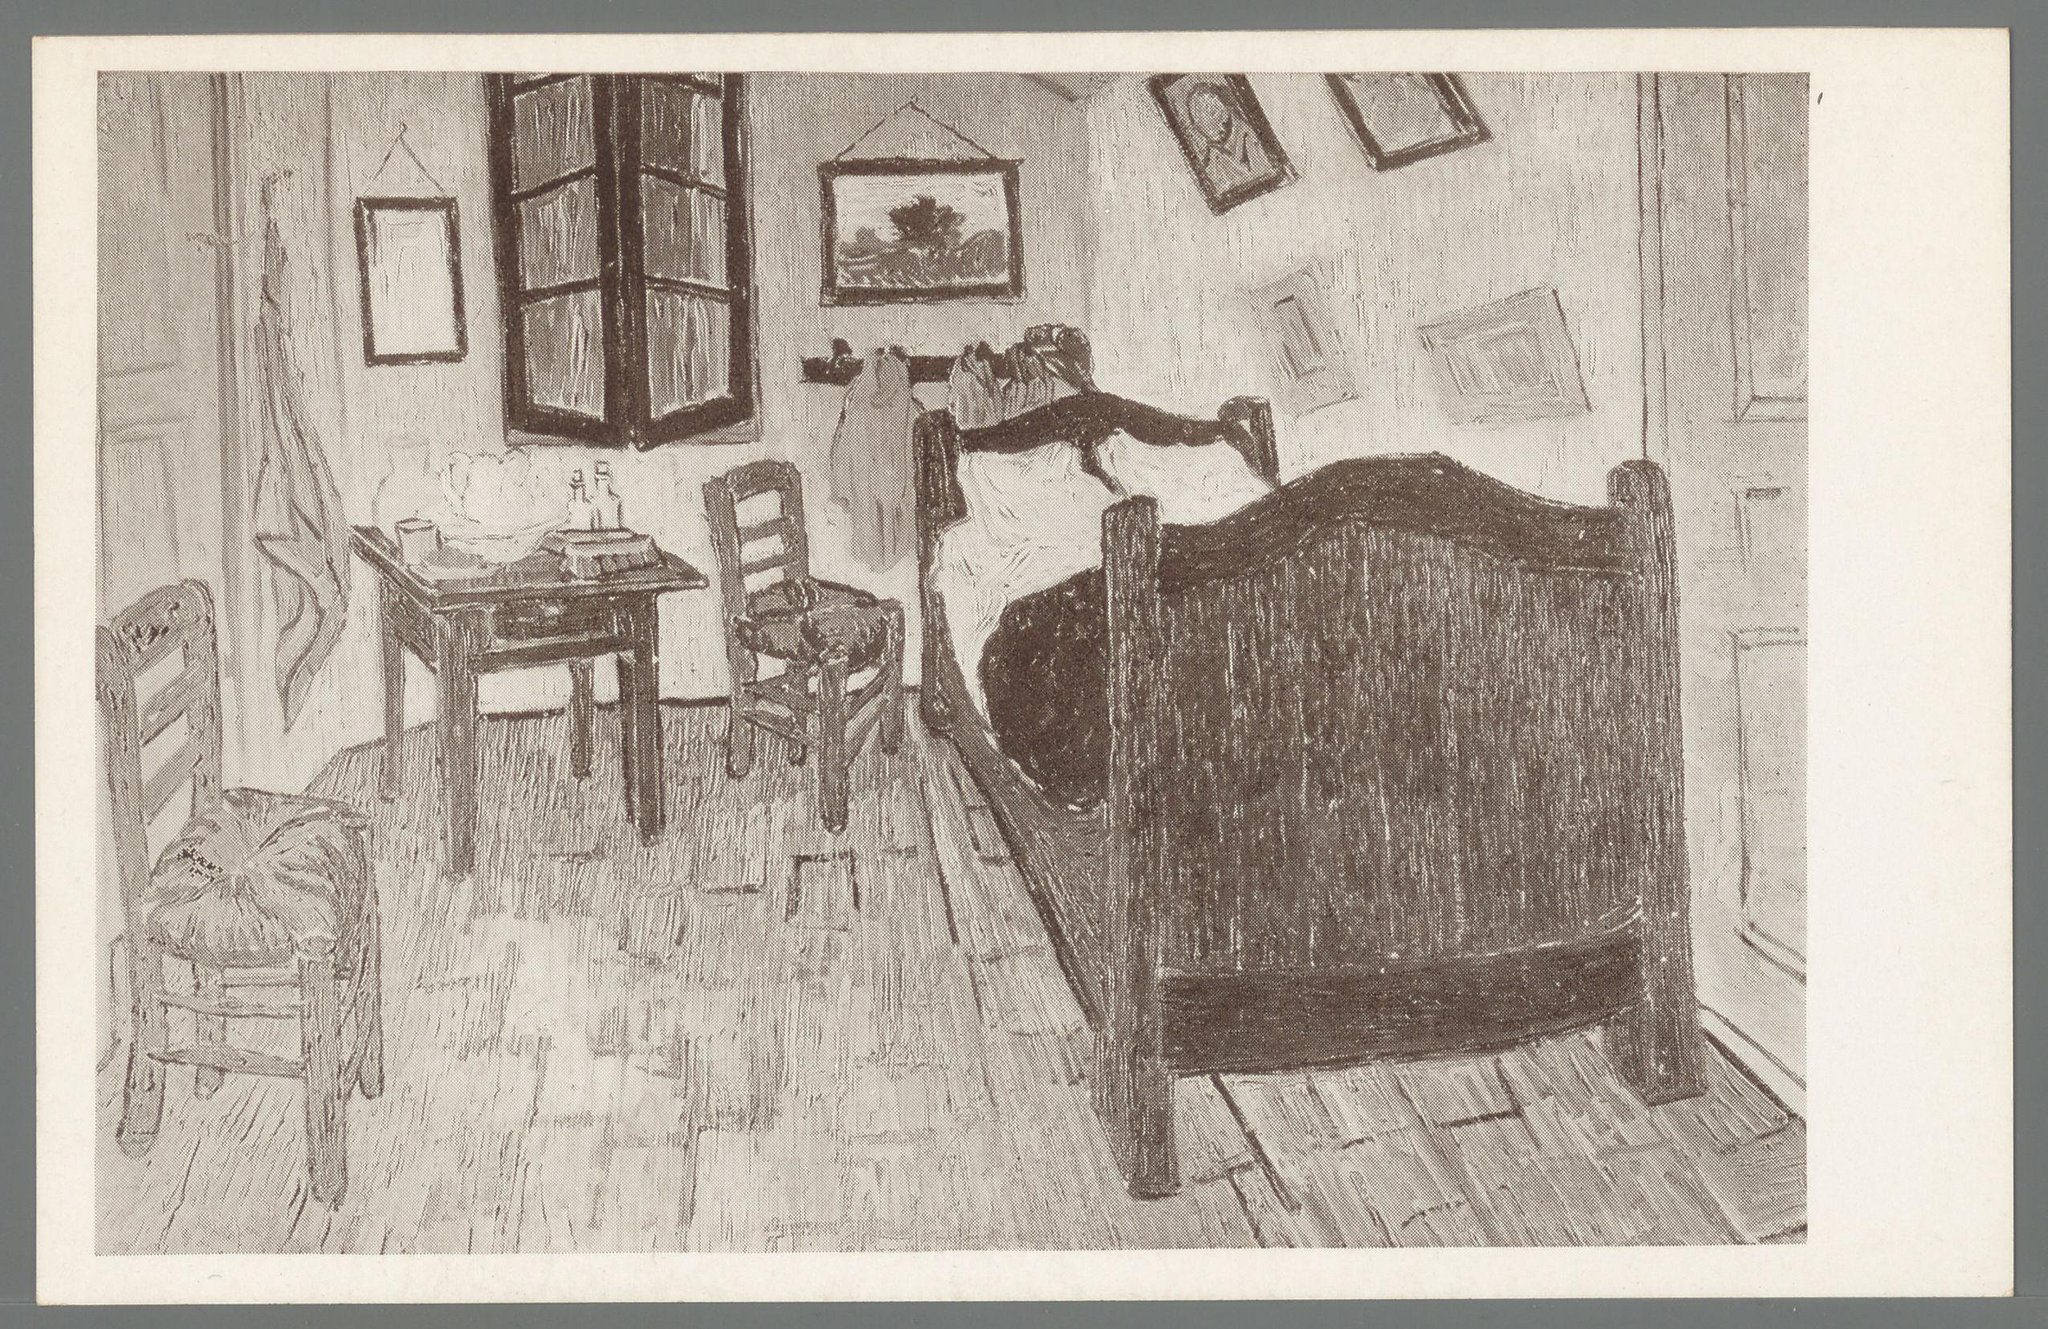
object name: reproduction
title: La chambre à Arles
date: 1926-1940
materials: cardboard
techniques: autotype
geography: chicago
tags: bed, picture, painting, bedroom